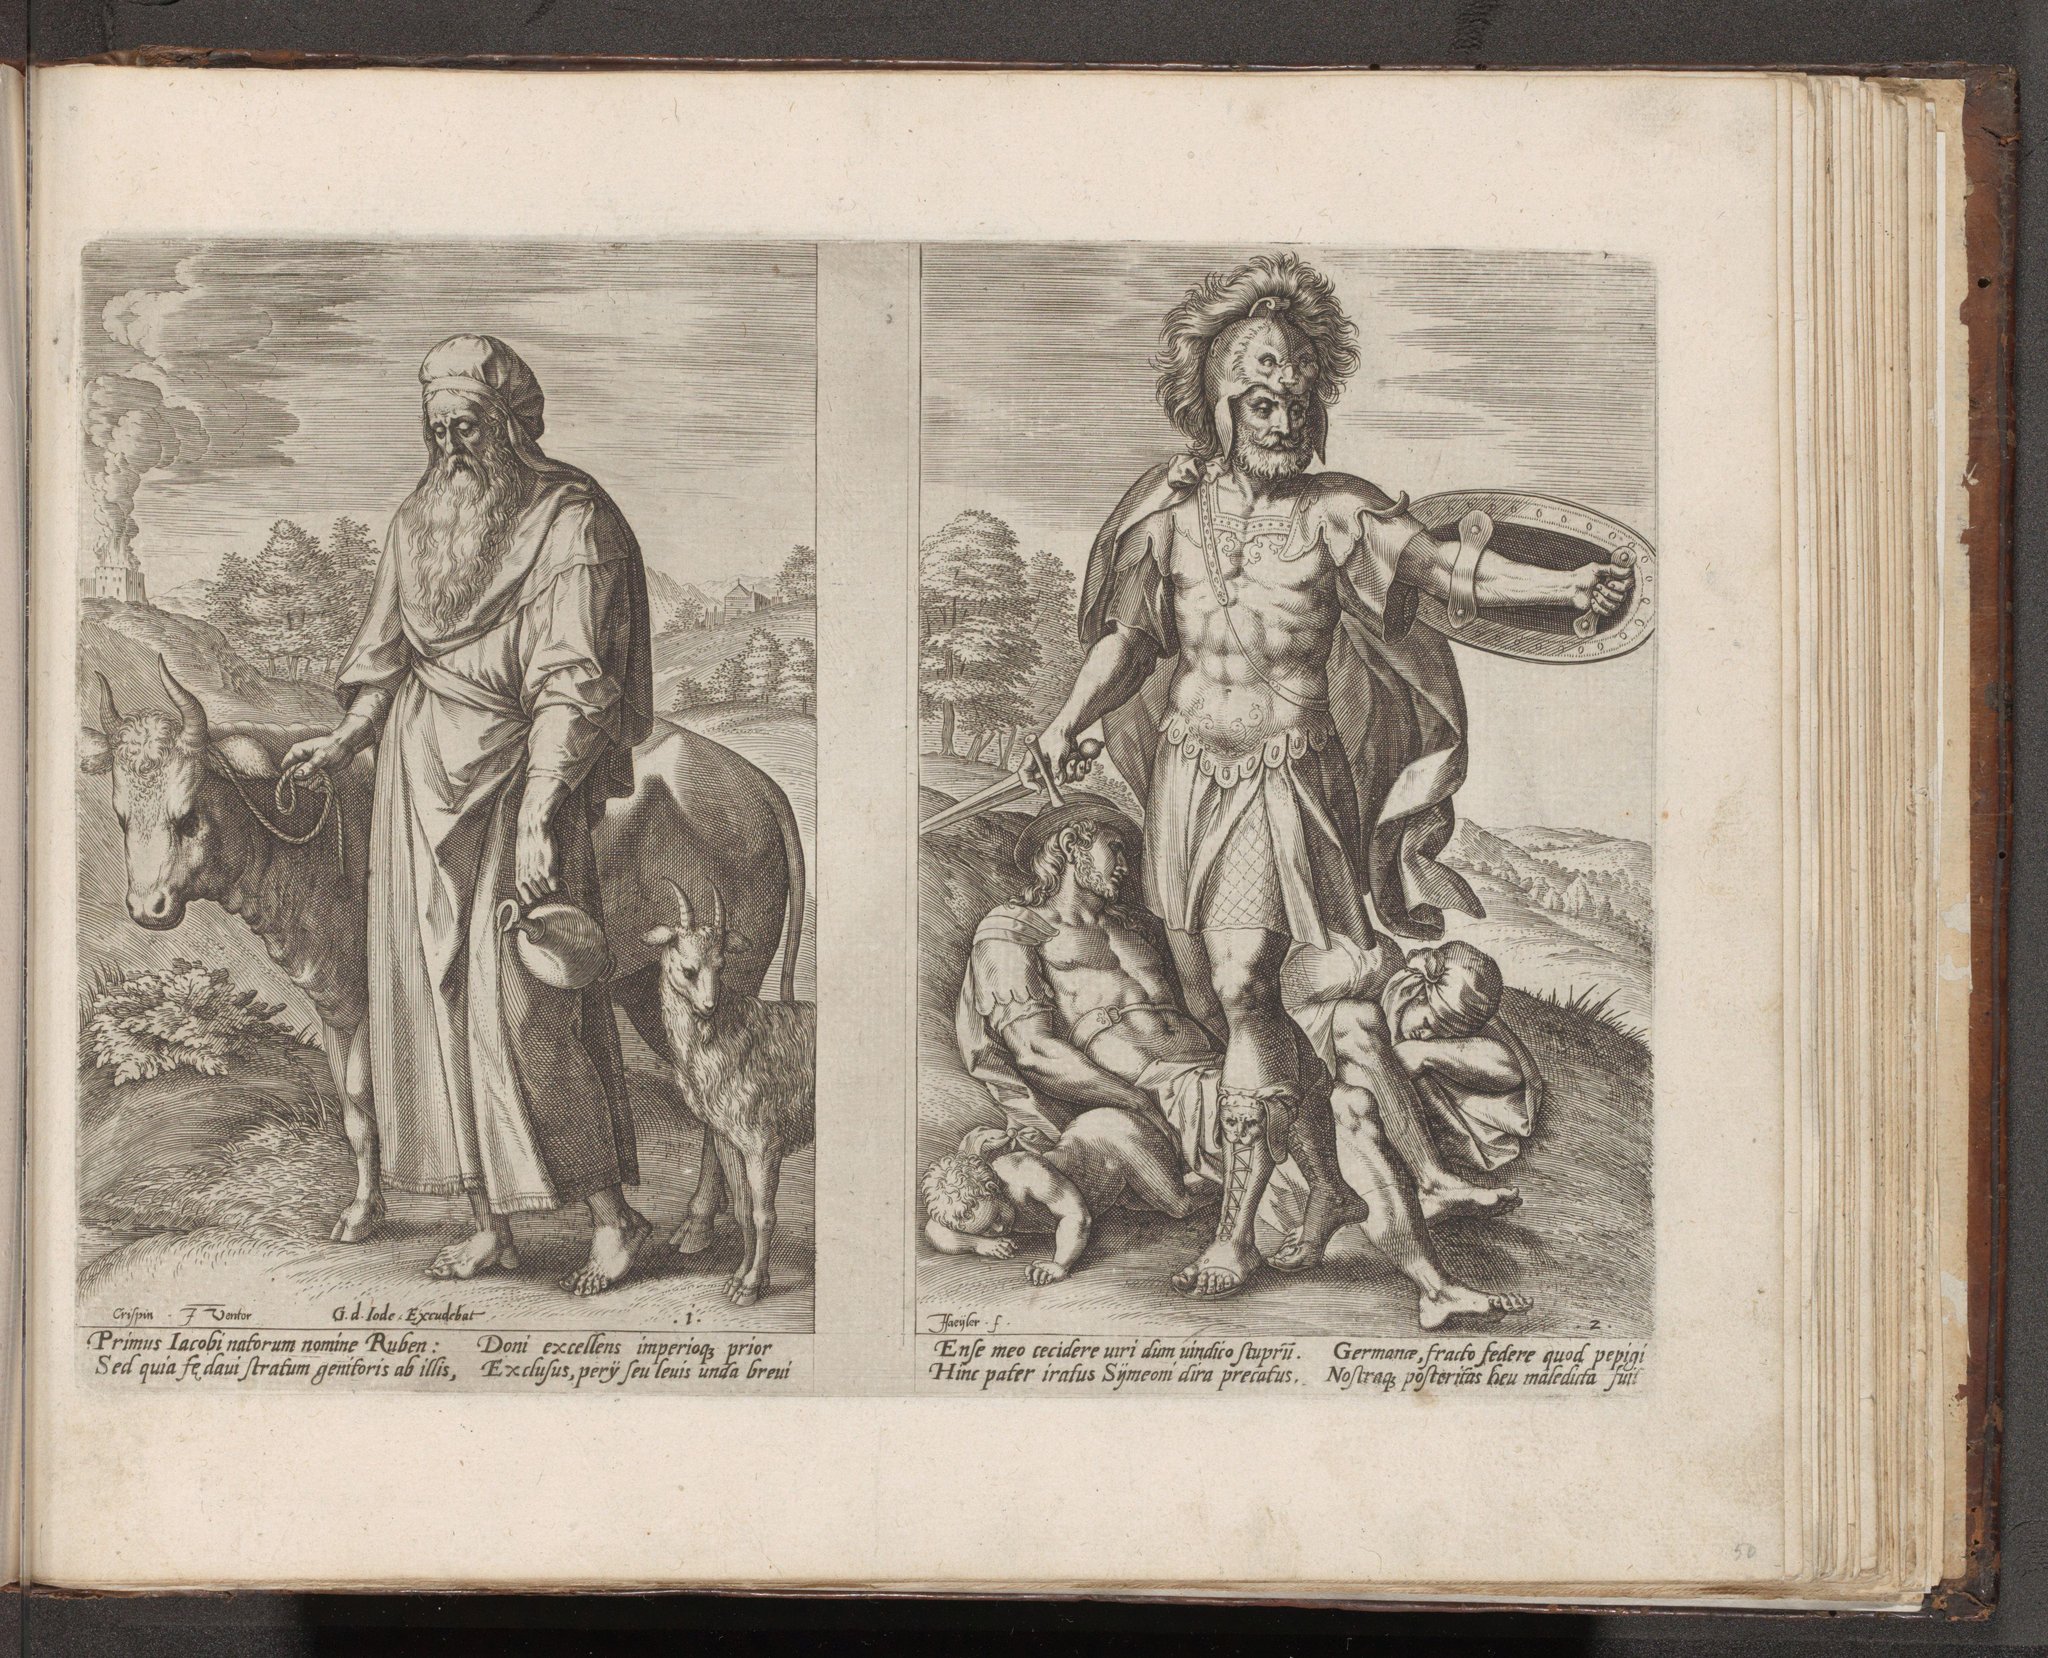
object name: album leaf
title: Thesaurus sacrarum historiaru[m] veteris testame[n]ti, elega[n]tissimis imaginibus expressu[m] excelle[n]tissimoru[m] in hac arte viroru[m] opera: nu[n]c primu[m] in luce[m] editus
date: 1579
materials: paper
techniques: engraving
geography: antwerp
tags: 11i611(simeon), 11i611(ruben)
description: Links stamvader Ruben, de oudste zoon van Jakob, in een landschap met een rund en een geitje naast zich. In zijn linkerhand een kruik. Rechts stamvader Simeon, de tweede zoon van Jakob, in wapenrusting in een landschap. Achter hem liggen de lijken van Sichem en twee van zijn mannen, die Simeon samen met Levi had gedood als wraak voor het onteren van zijn zus Dina. Onder de voorstellingen een verwijzing in het Latijn naar de Bijbeltekst. Prent maakt deel uit van een album.